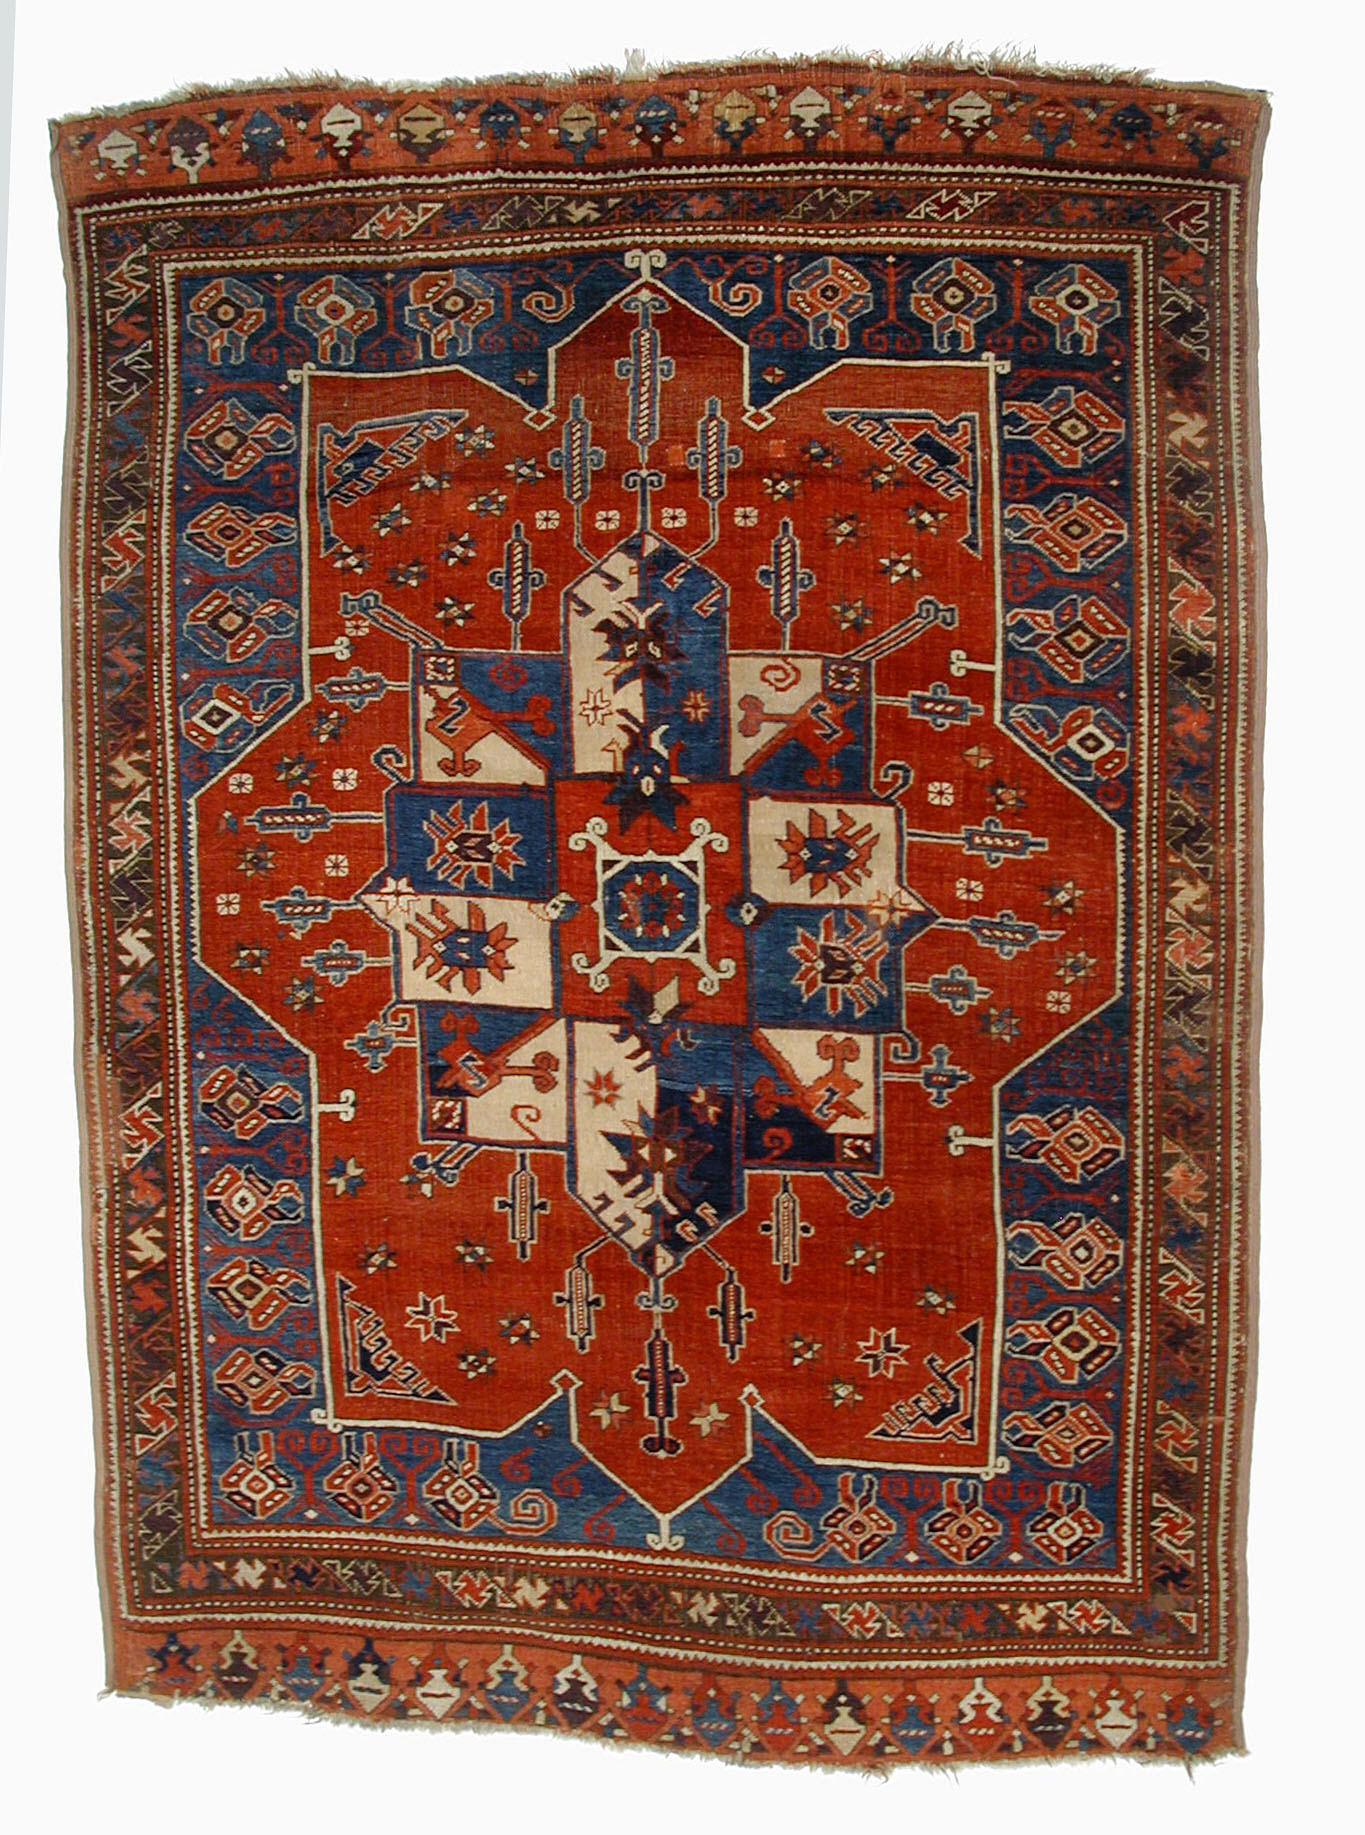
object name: carpet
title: Tribal Carpet with Medallion Design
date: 1701-1800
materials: wool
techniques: pile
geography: turkey